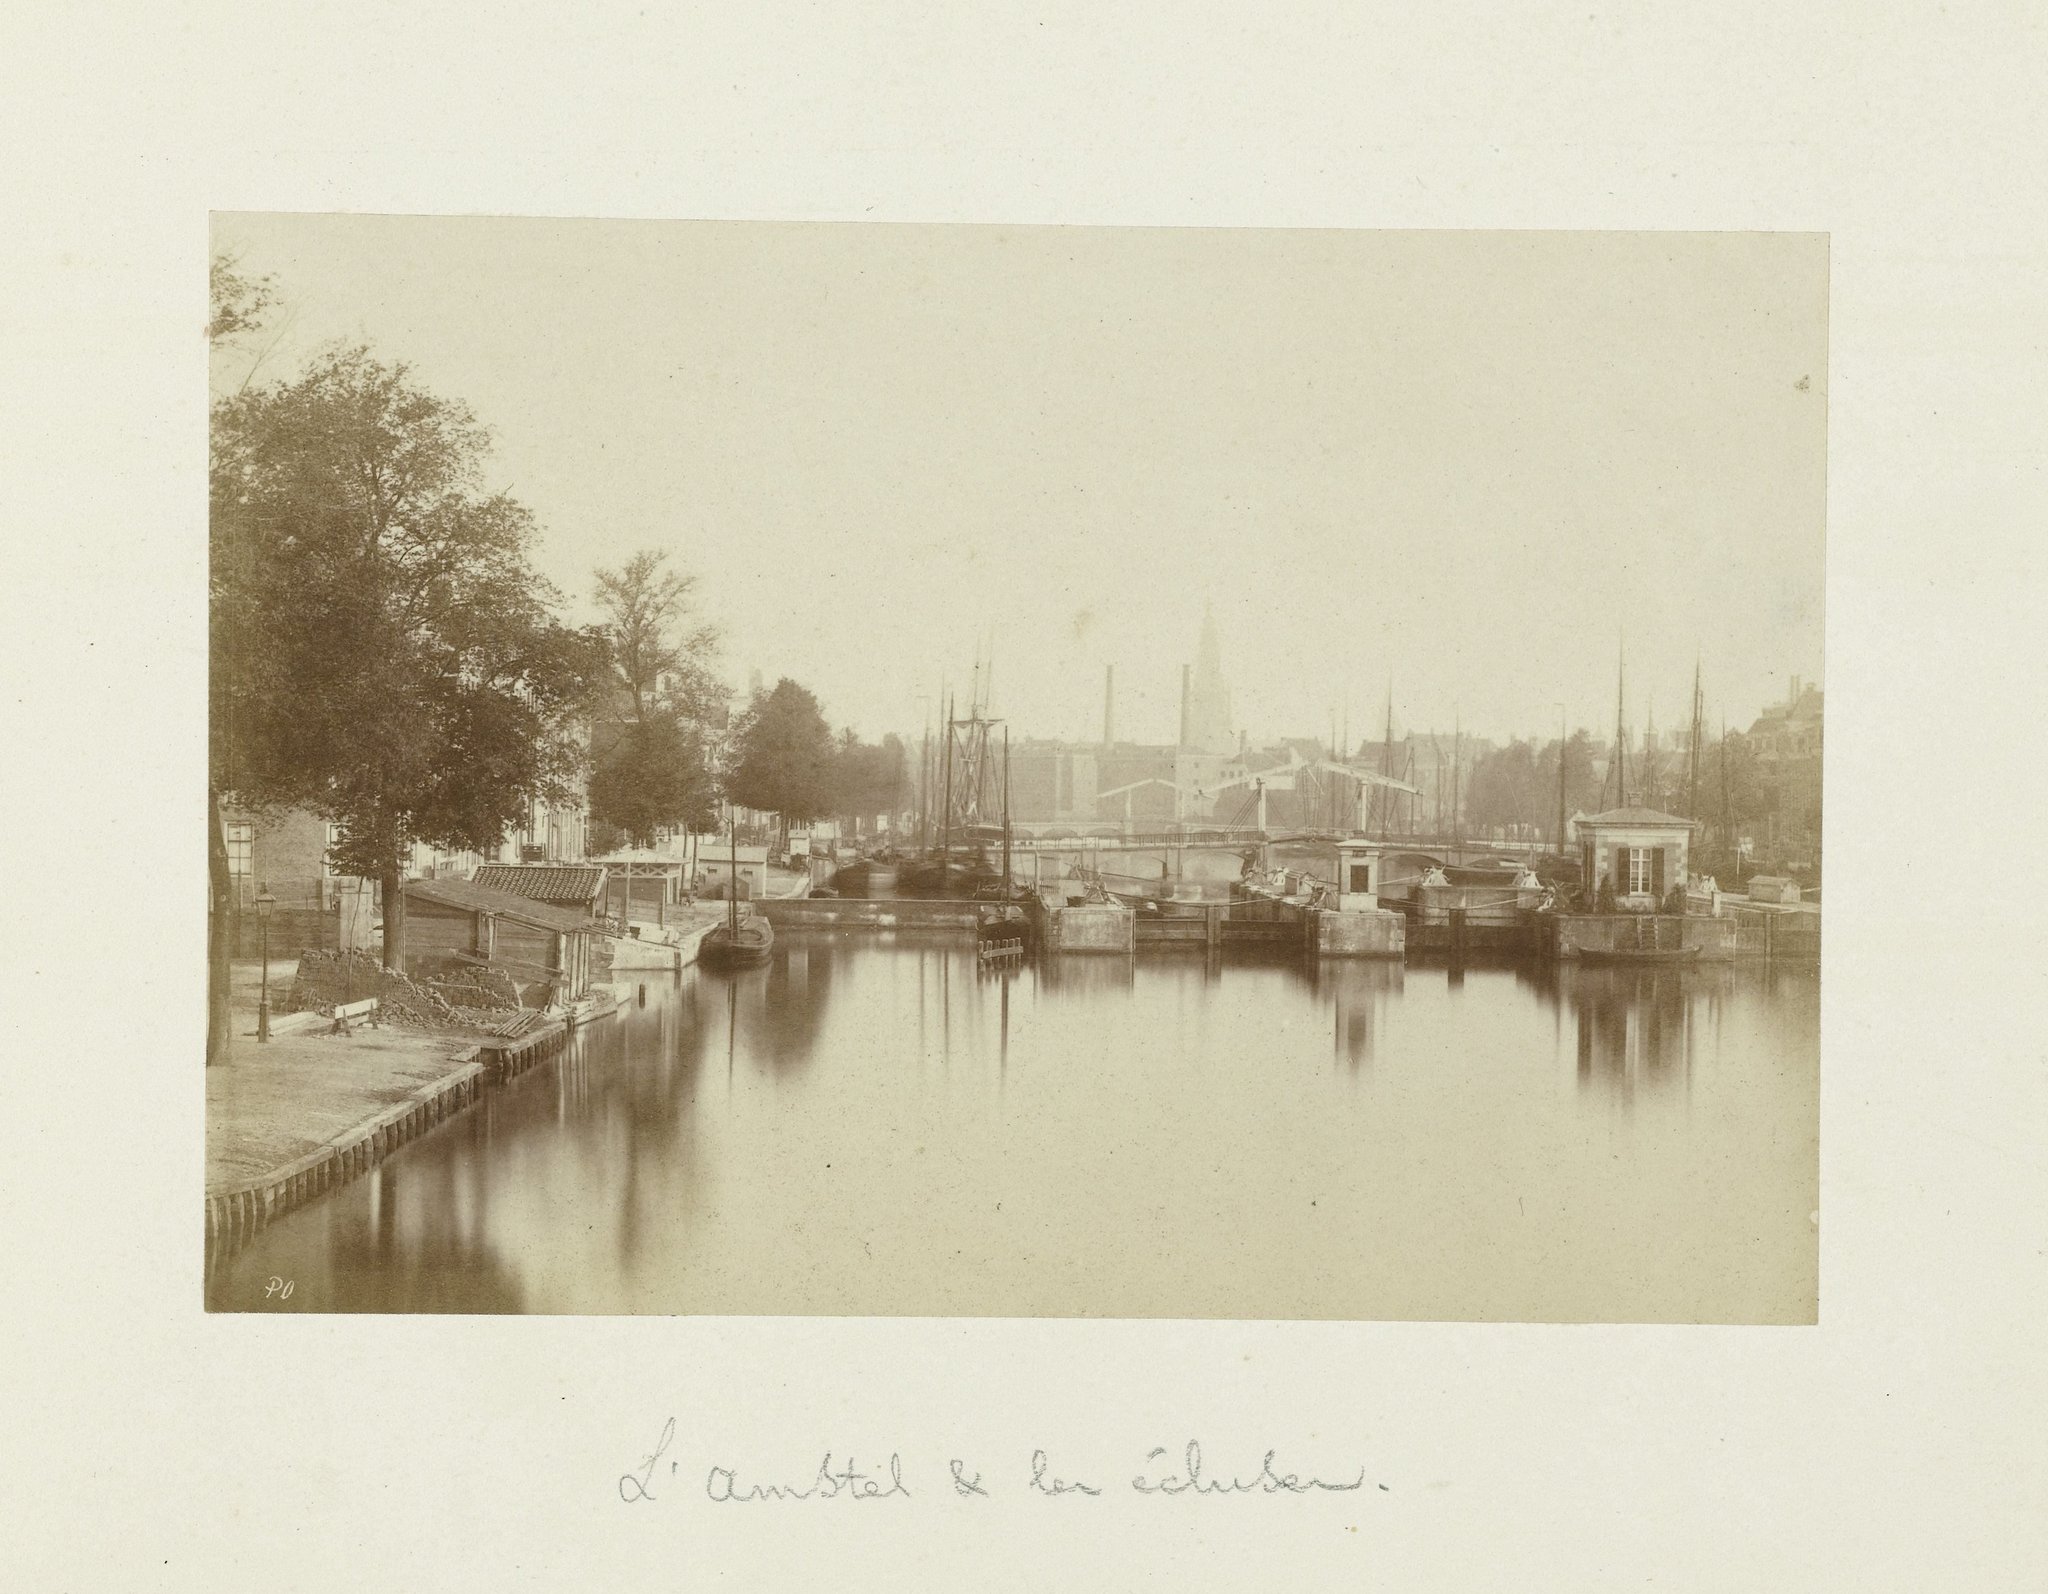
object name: page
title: Sluizen in de Amstel, gezicht vanaf de Hogesluis met op de achtergrond de Magere Brug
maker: pieter oosterhuis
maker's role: draughtsman, print maker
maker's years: 1816-1885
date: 1855-1860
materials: paper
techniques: albumen print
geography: amsterdam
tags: sluice, weir, amsterdam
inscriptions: inscription: ‘l'Amstel & les écluses’